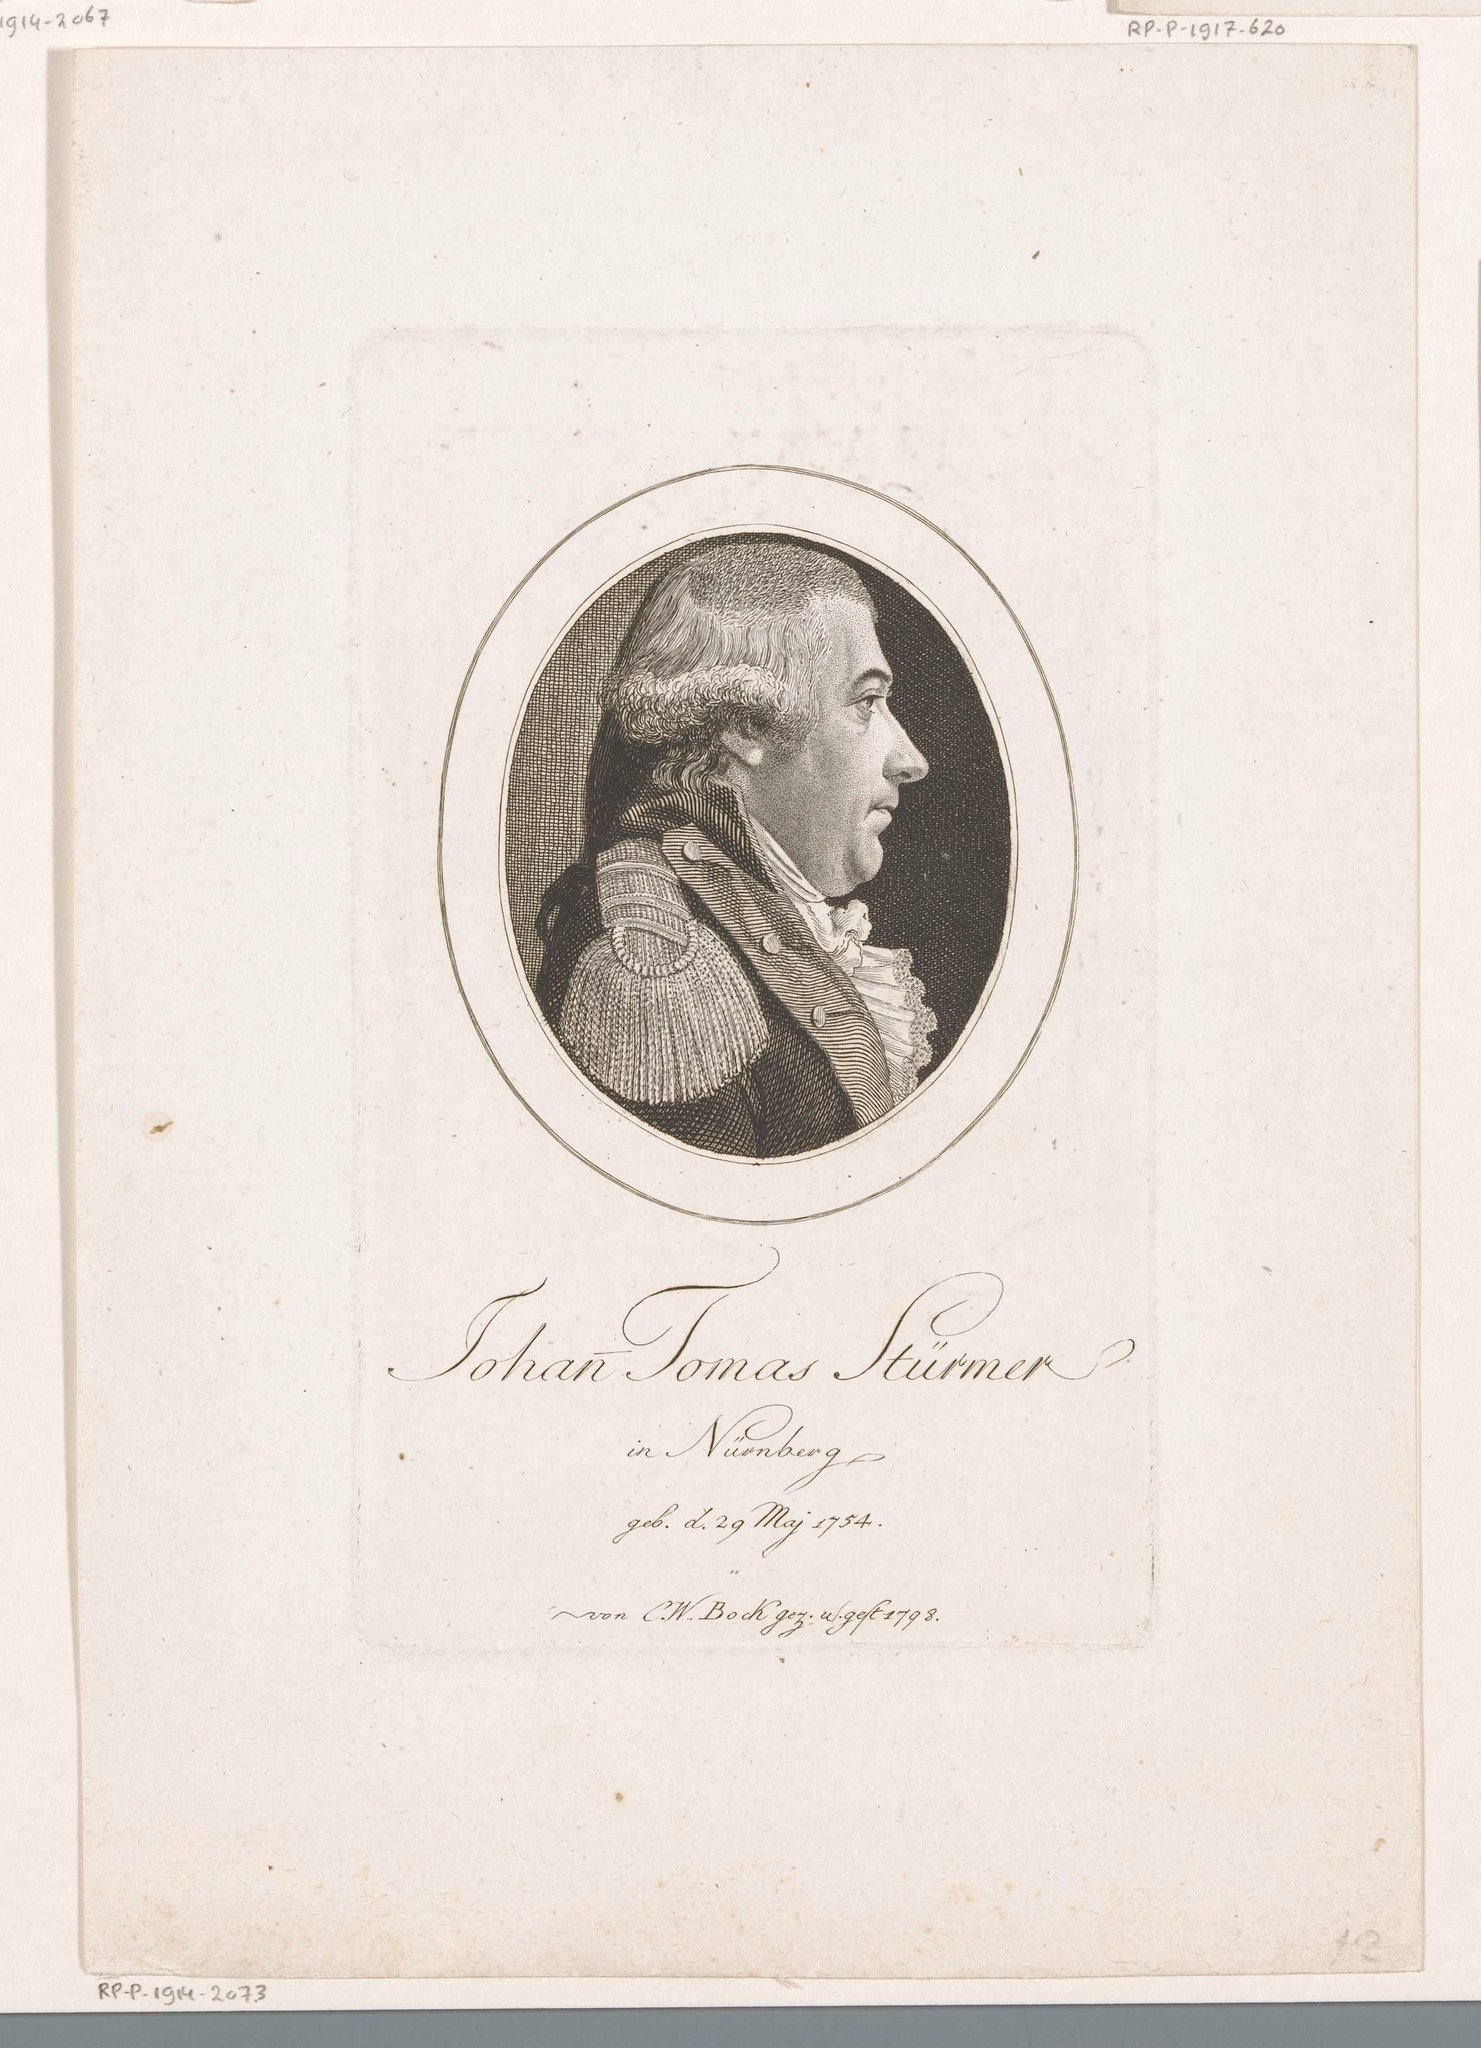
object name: print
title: Portret van Johann Thomas Stürmer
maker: christoph wilhelm bock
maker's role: print maker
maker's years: 1755-1836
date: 1798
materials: paper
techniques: engraving, etching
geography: nuremberg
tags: historical persons, (military) uniforms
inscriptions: collector's mark: Lugt 2228